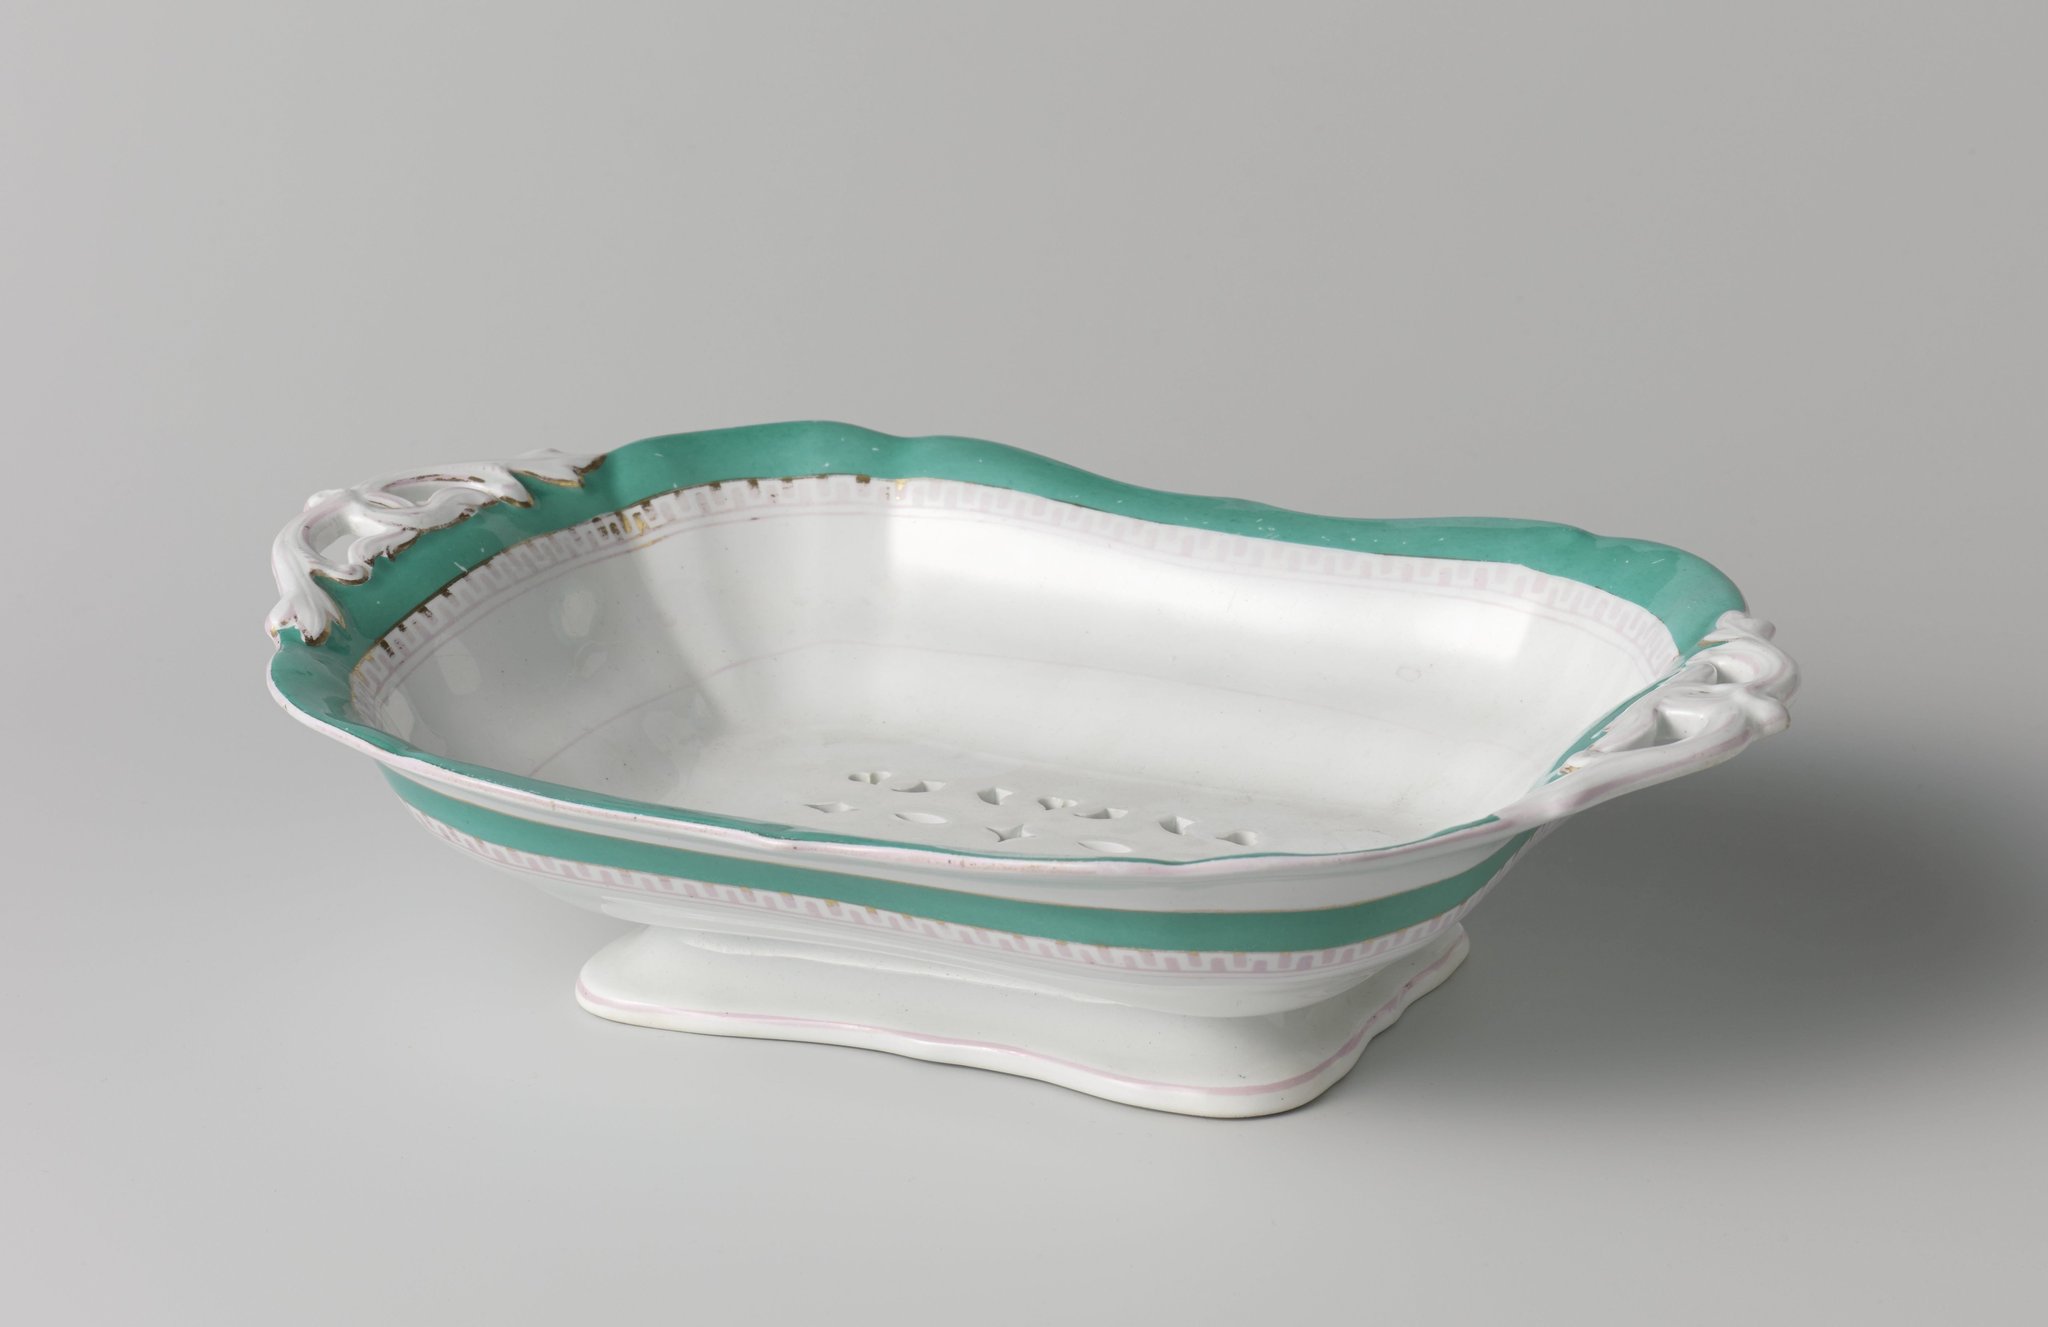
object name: vessel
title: Treeft op voet met groene rand en gouden Griekse band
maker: petrus regout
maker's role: plateelbakker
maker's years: 1801-1879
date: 1865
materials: earthenware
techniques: transfer decoration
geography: maastricht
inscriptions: check stamp: ‘P. REGOUT // MAASTRICHT // 2X 22’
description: Treeft op voet van aardewerk, langwerpig, geschulpt, met groene rand en gouden Griekse band.